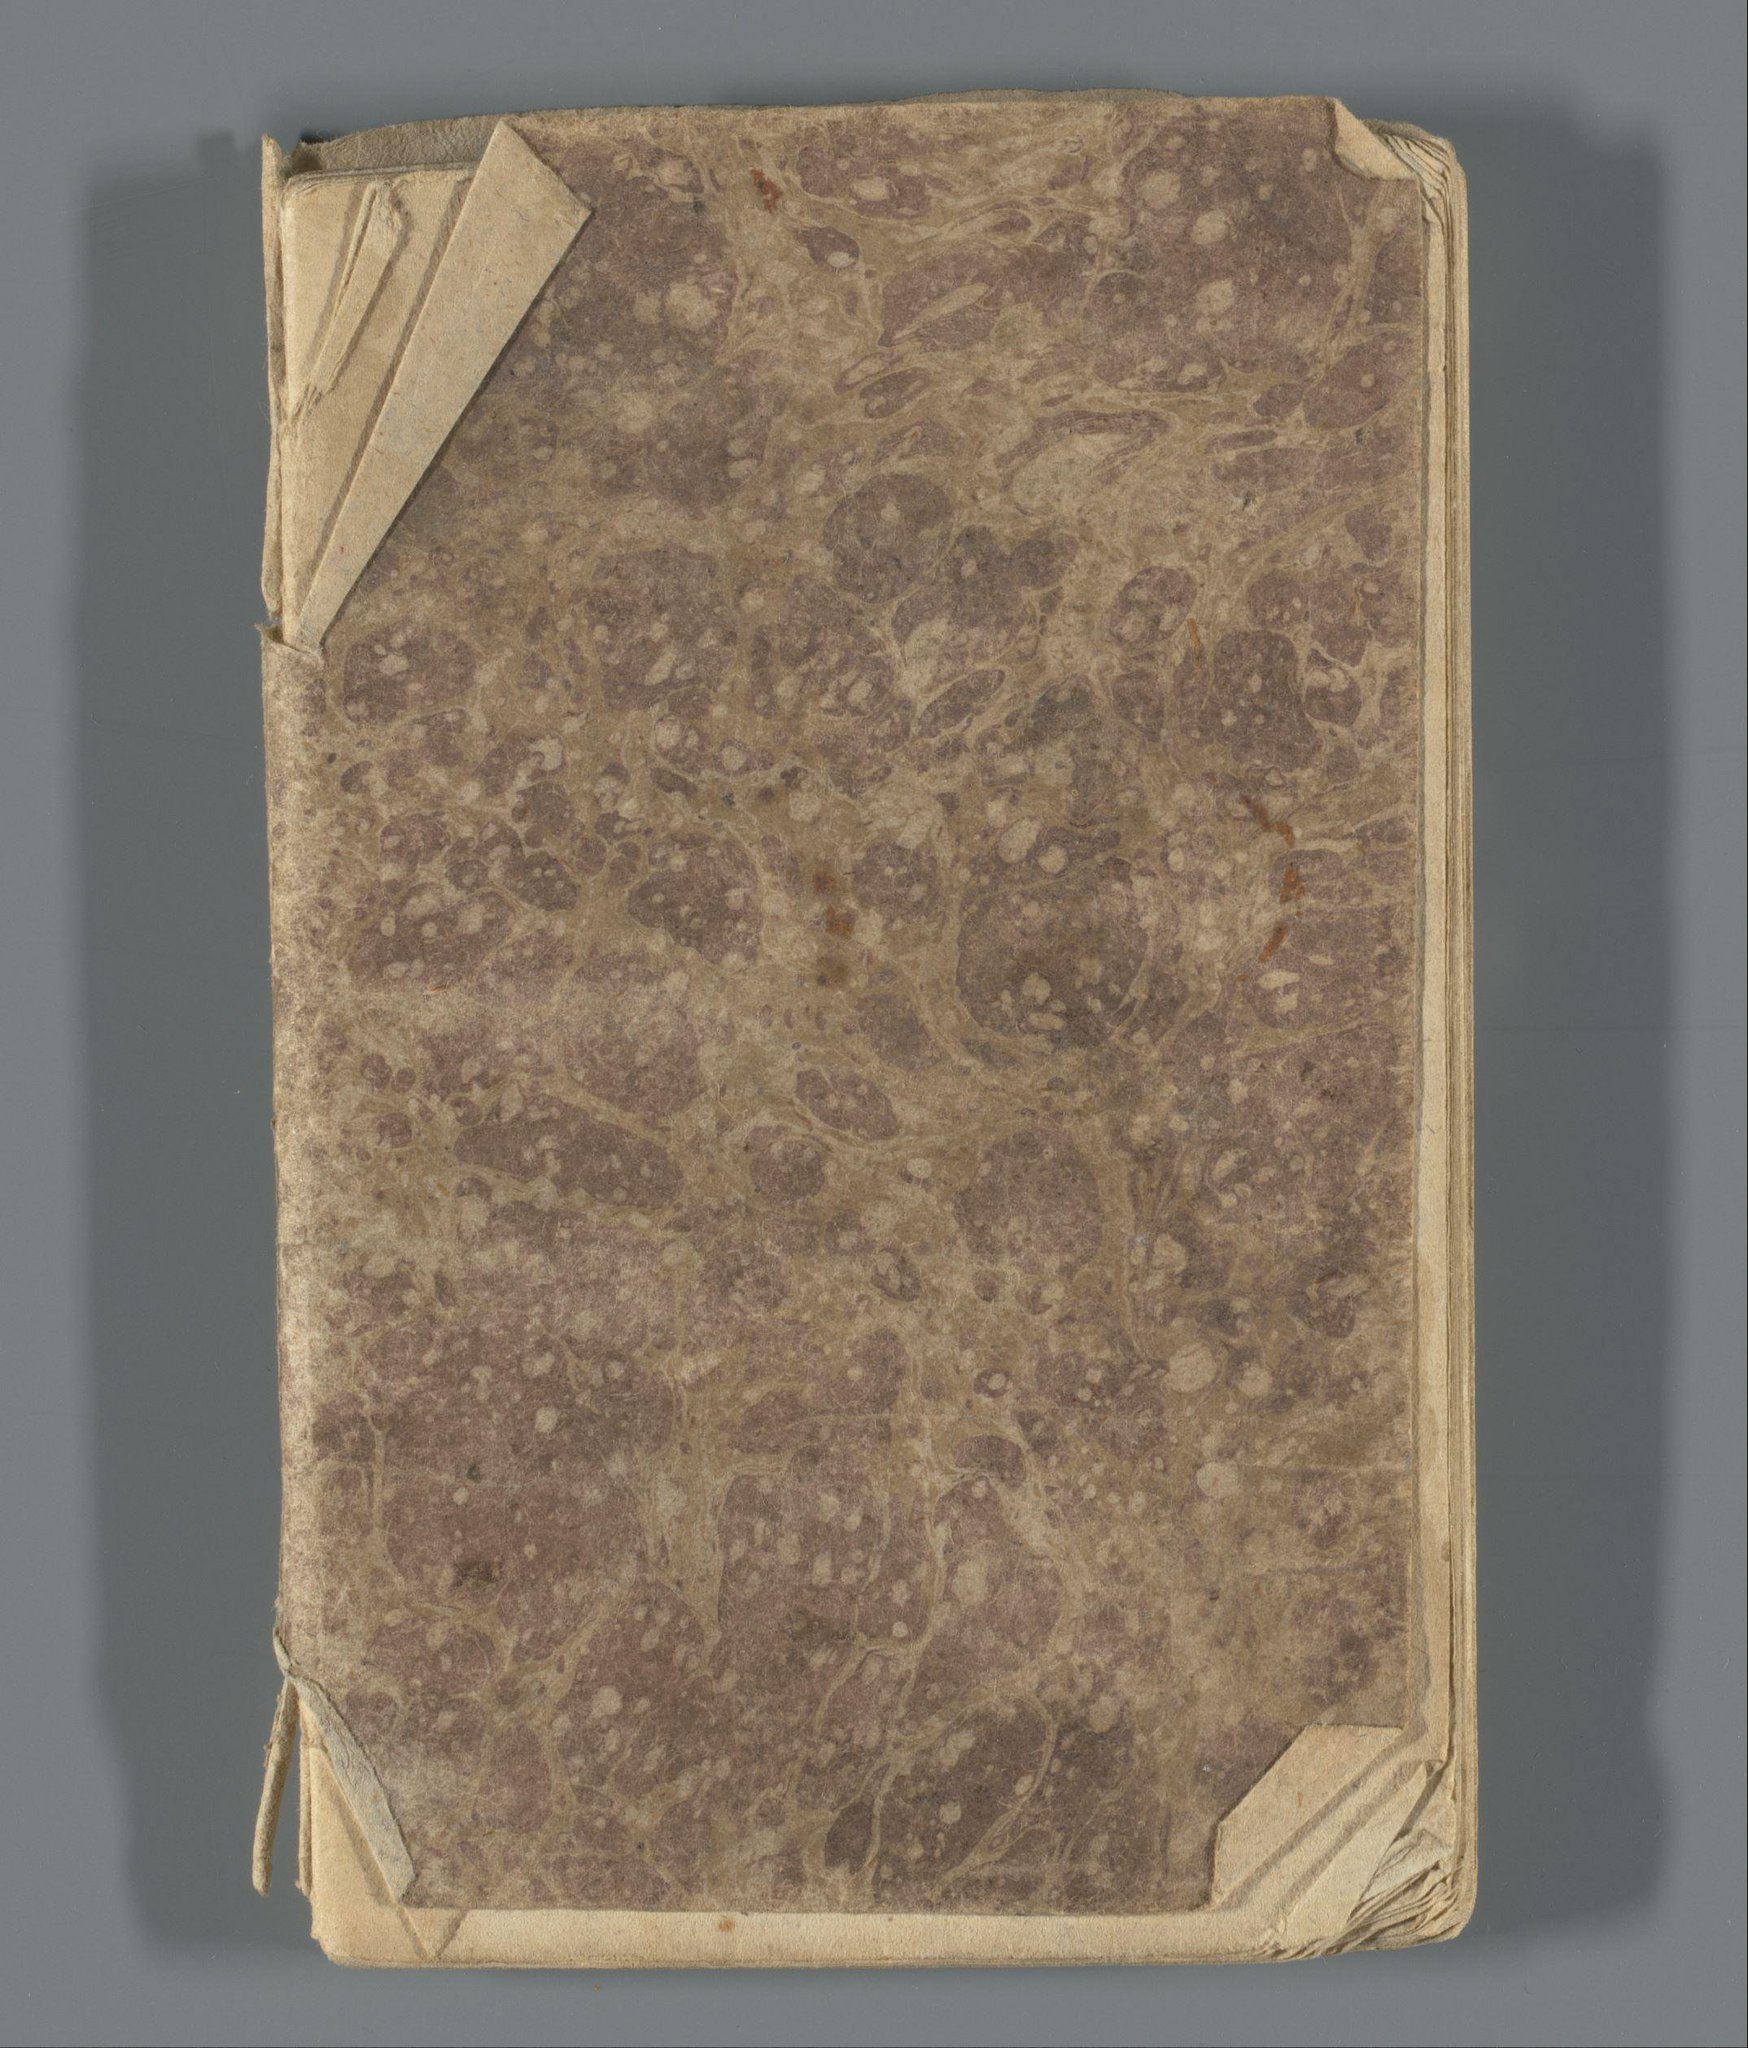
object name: book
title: Naamlyst en rangschikking van het vaste corps zee-officieren de Bataafsche Republiek. Zo als hetzelve zich bevond, op de n eersten February 1804.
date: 1804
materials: paper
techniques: printing, sewing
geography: the hague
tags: batavian republic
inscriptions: date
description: Namenlijst van 96 genummerde pp in violet gemarmerd papieren ovalen omslag. Gedateerd; titelp, m. o.: 1804. Omslag gescheurd en vele ezelsoren in het boek.